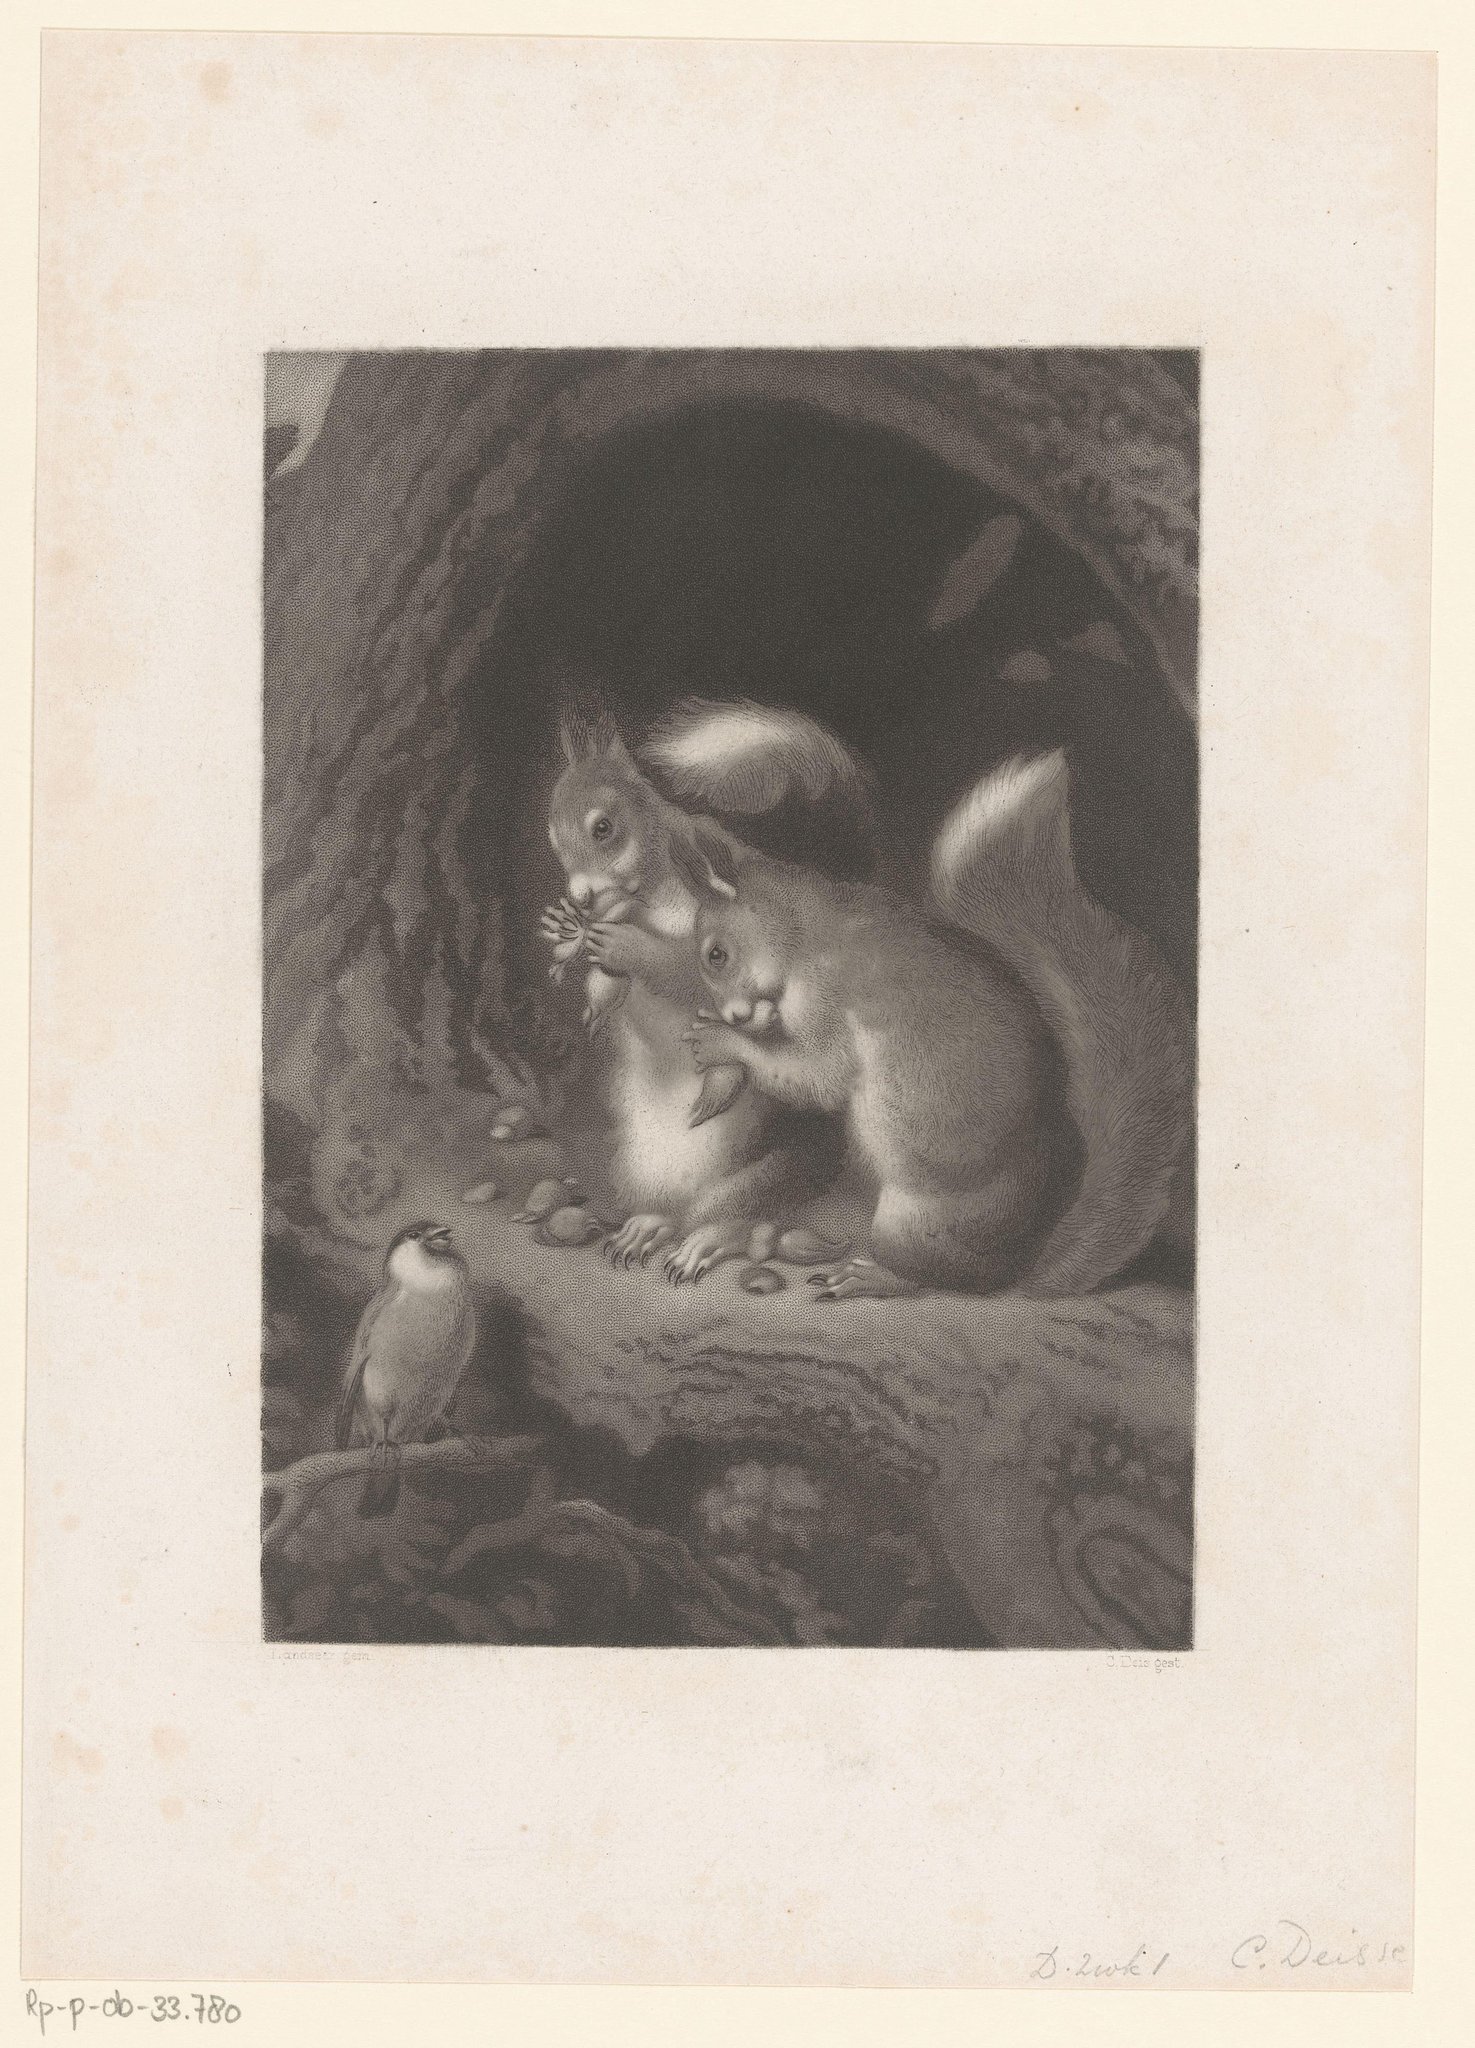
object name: print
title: Twee etende eekhoorns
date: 1820-1884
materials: paper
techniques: etching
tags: birds, fruits: nuts, rodents: squirrel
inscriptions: collector's mark: Lugt 2228